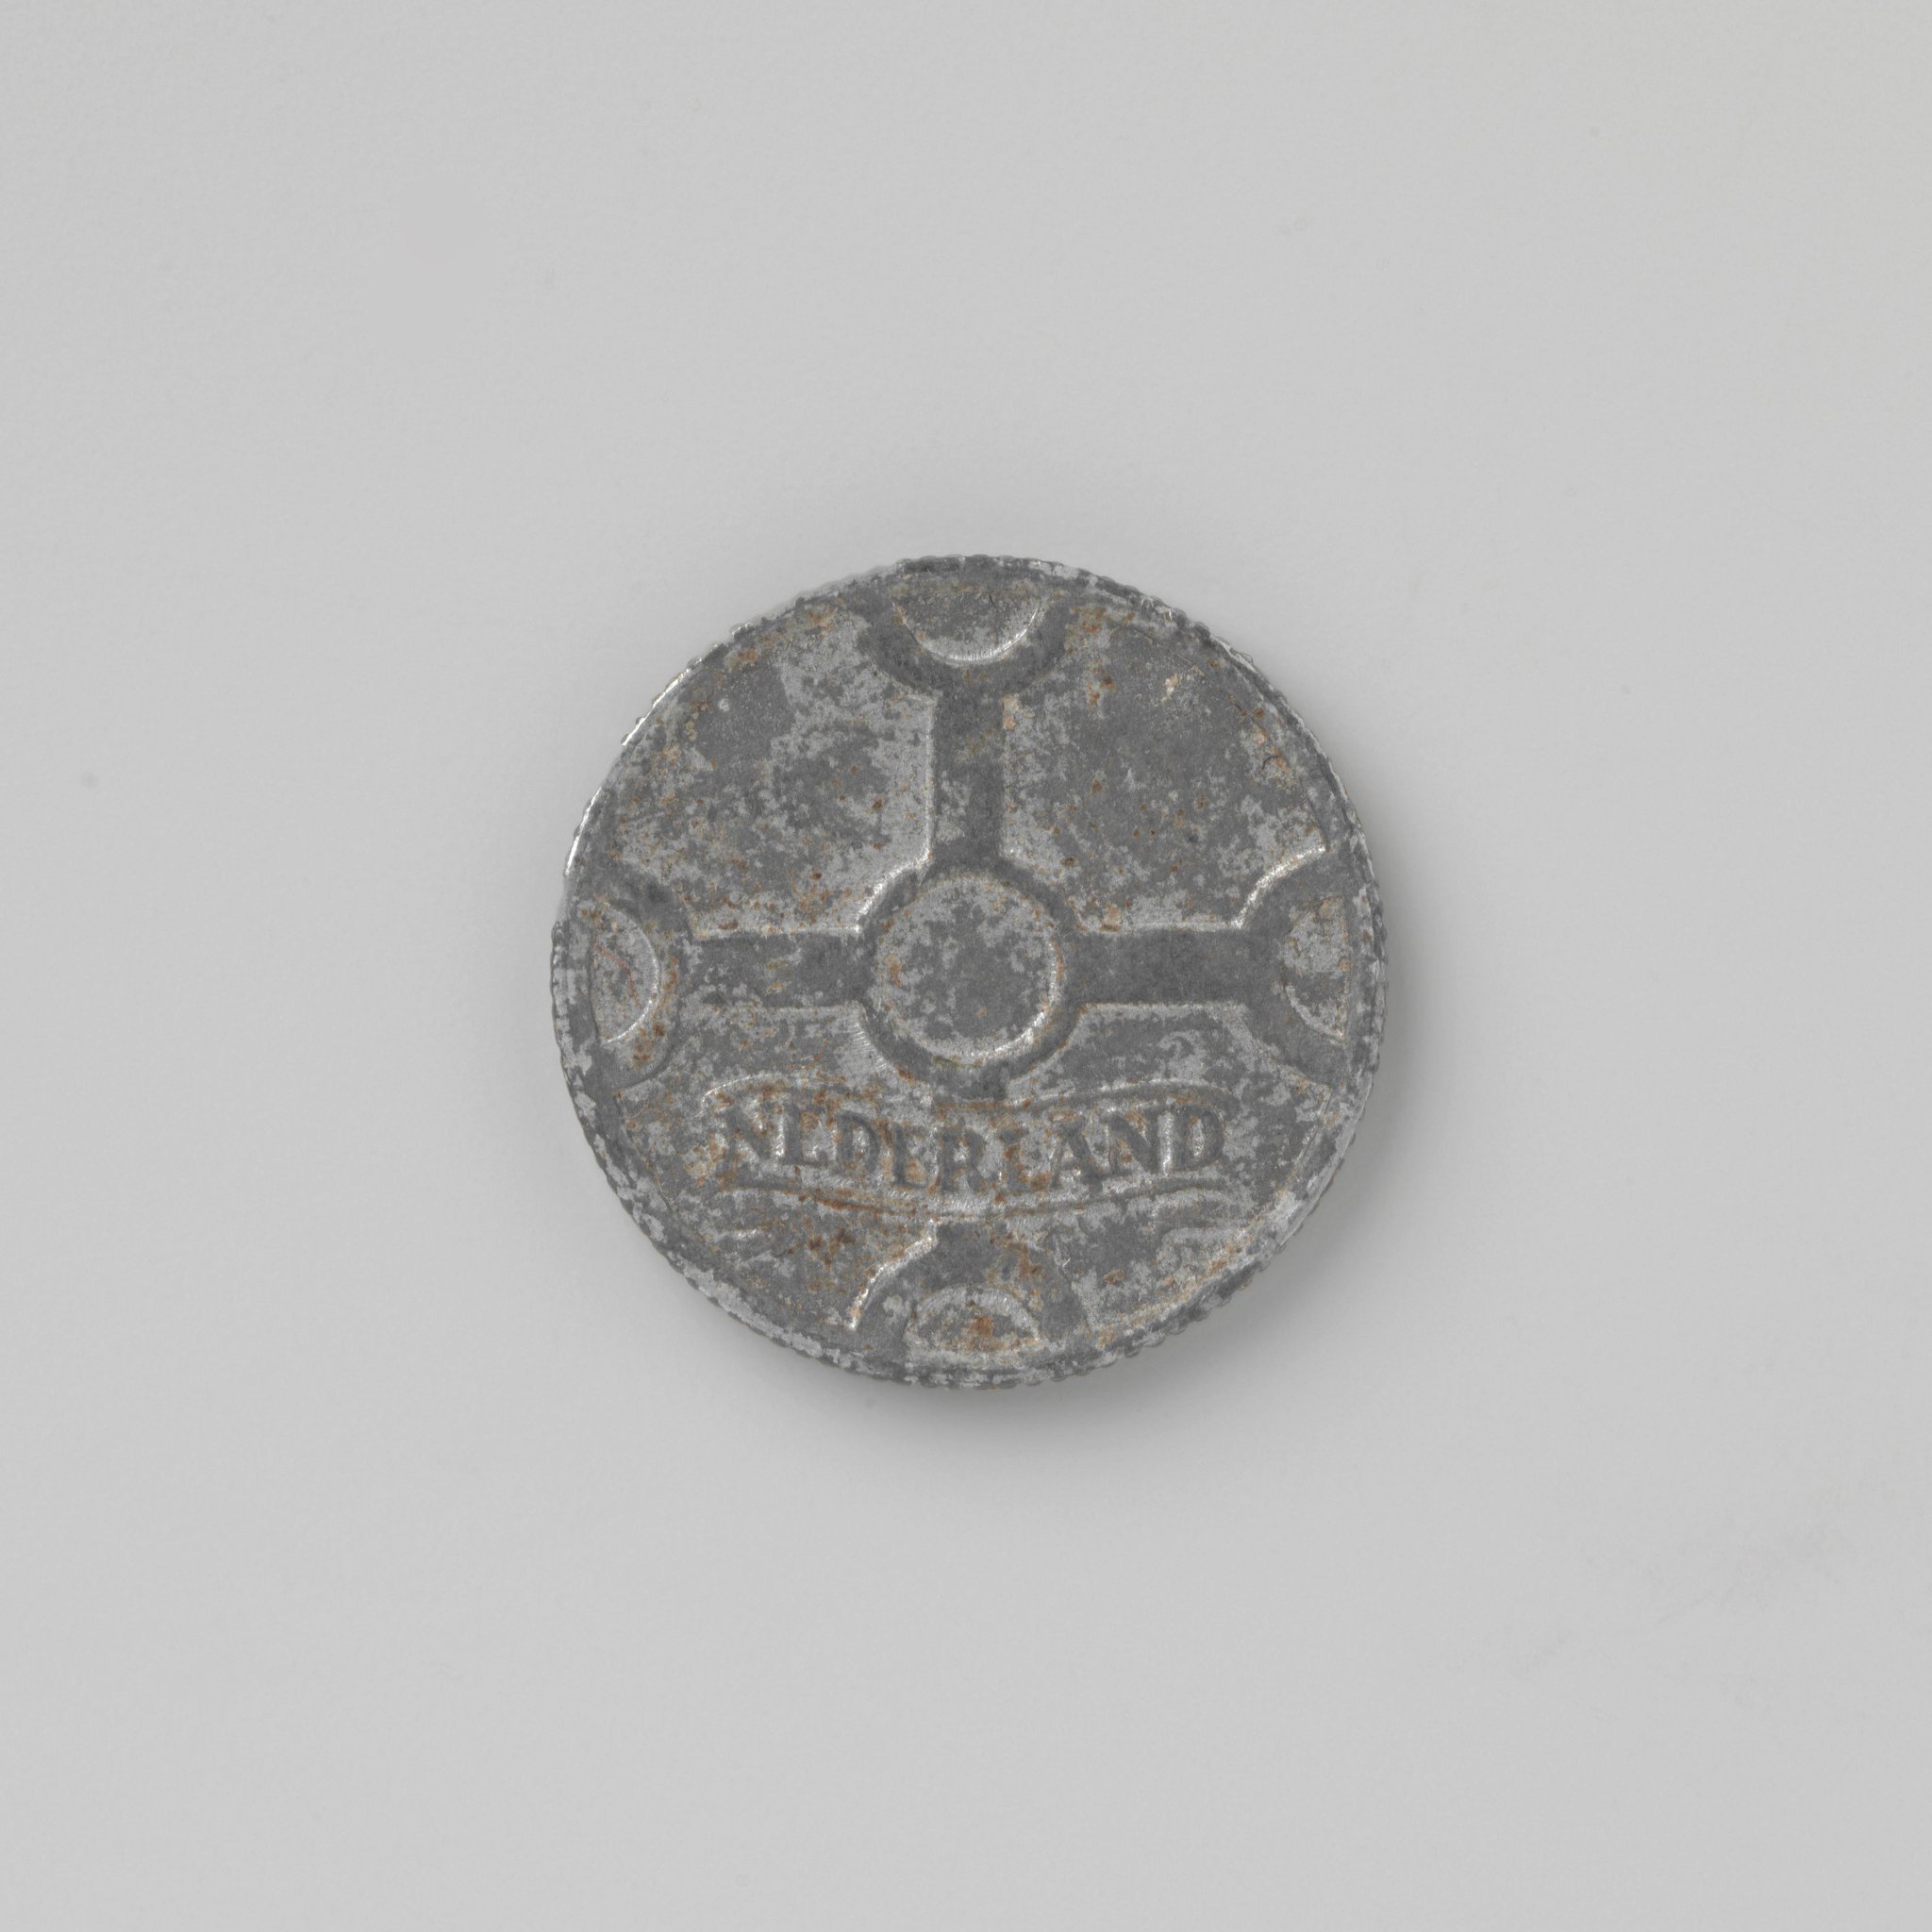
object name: coin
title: Nederlandse cent,1944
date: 1944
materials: zinc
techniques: striking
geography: utrecht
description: Zinken munt. Voorzijde: rechtkruis. Keerzijde: waarde-aanduiding 1 ct, rechts vier golven en een korenaar. daaronder op een band jaartal. Kartelrand.